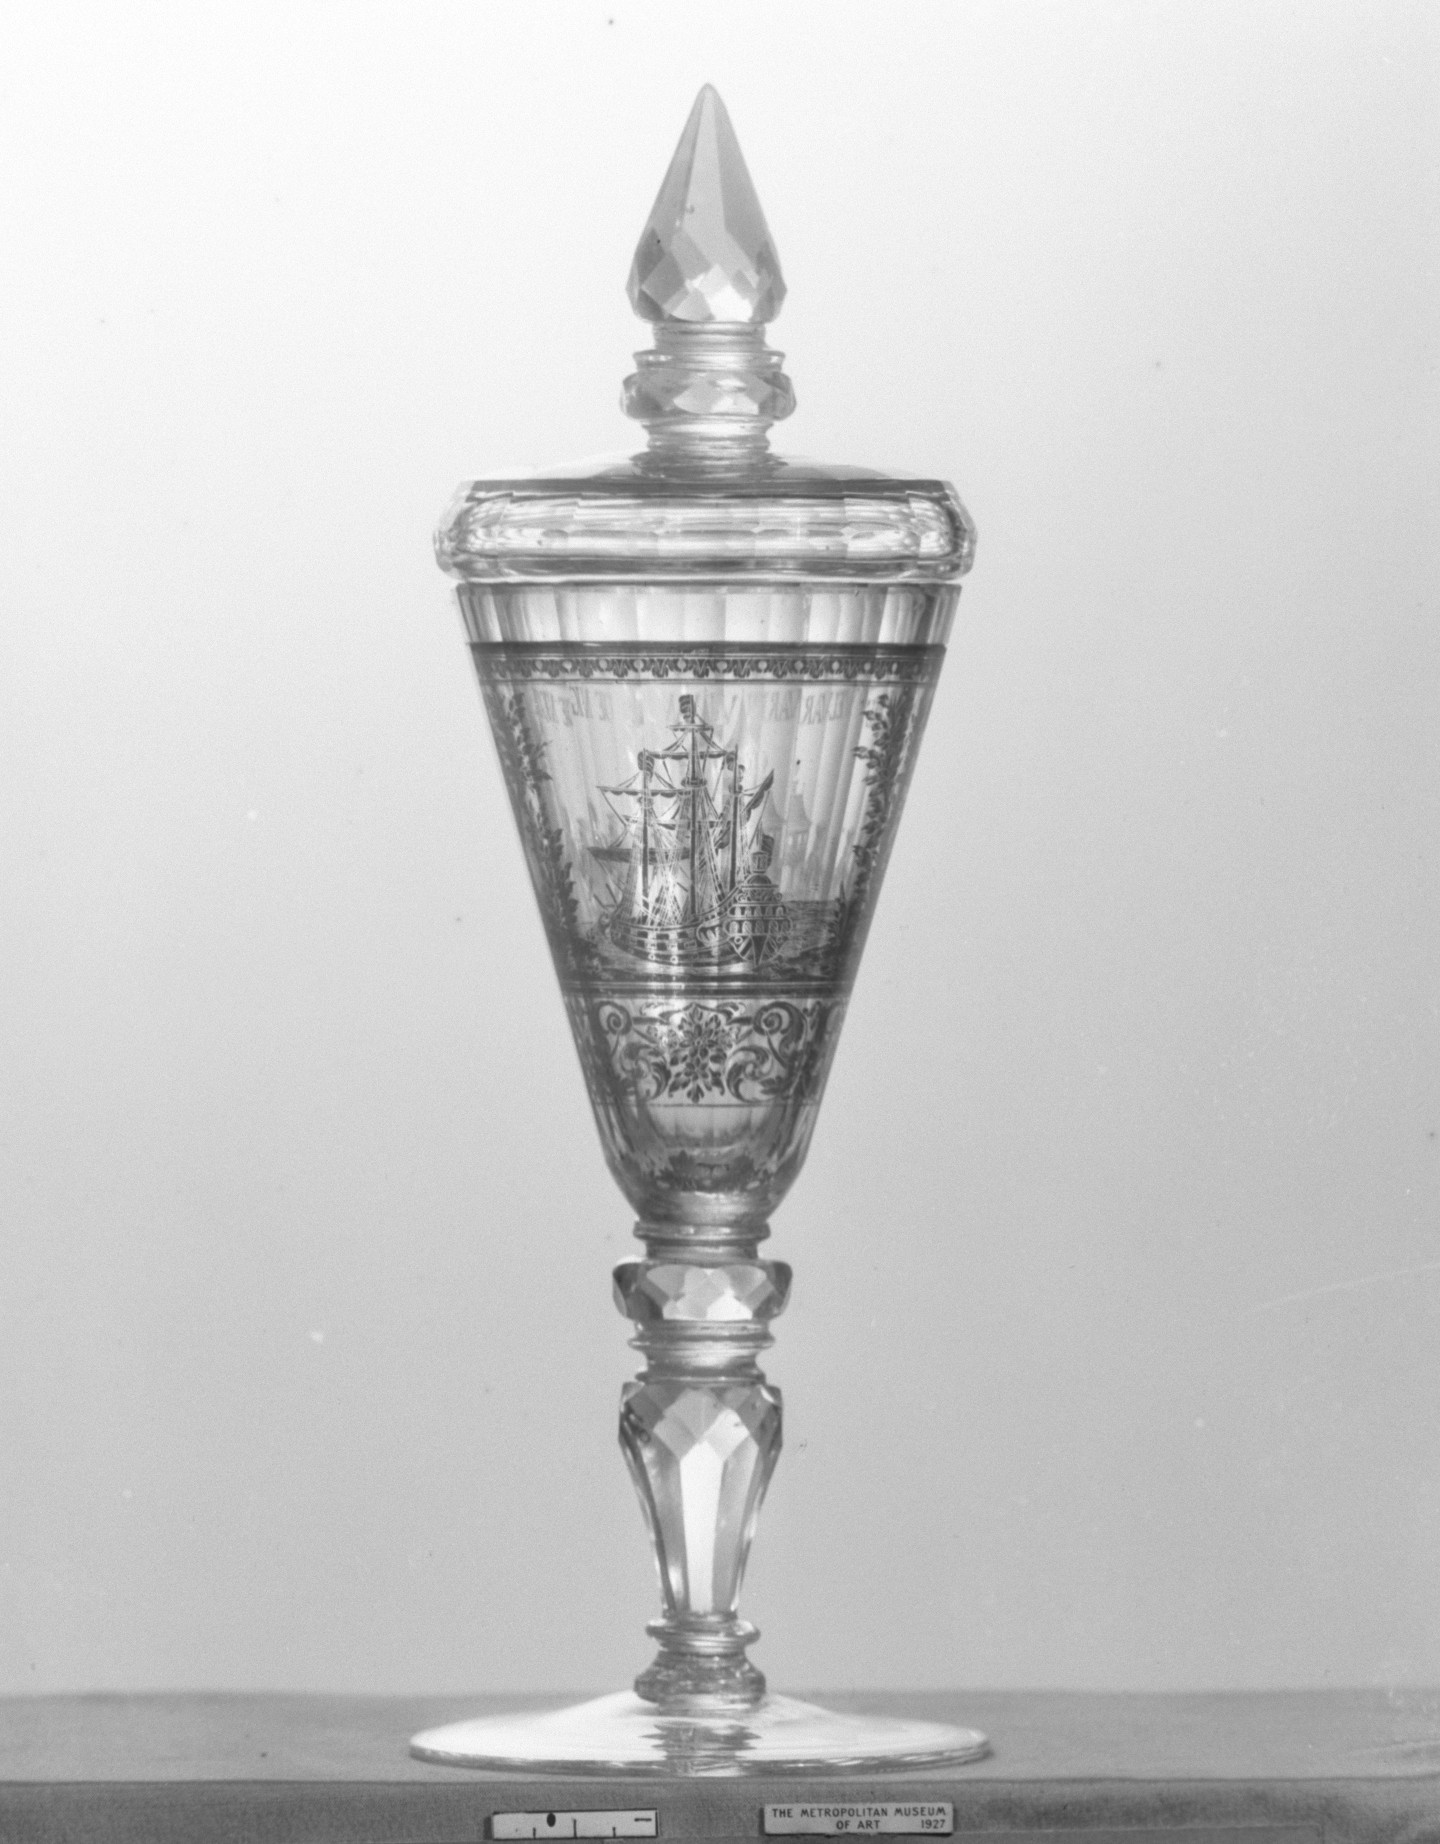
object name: standing cup with cover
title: Allegory of Trade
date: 1730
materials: glass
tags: ships